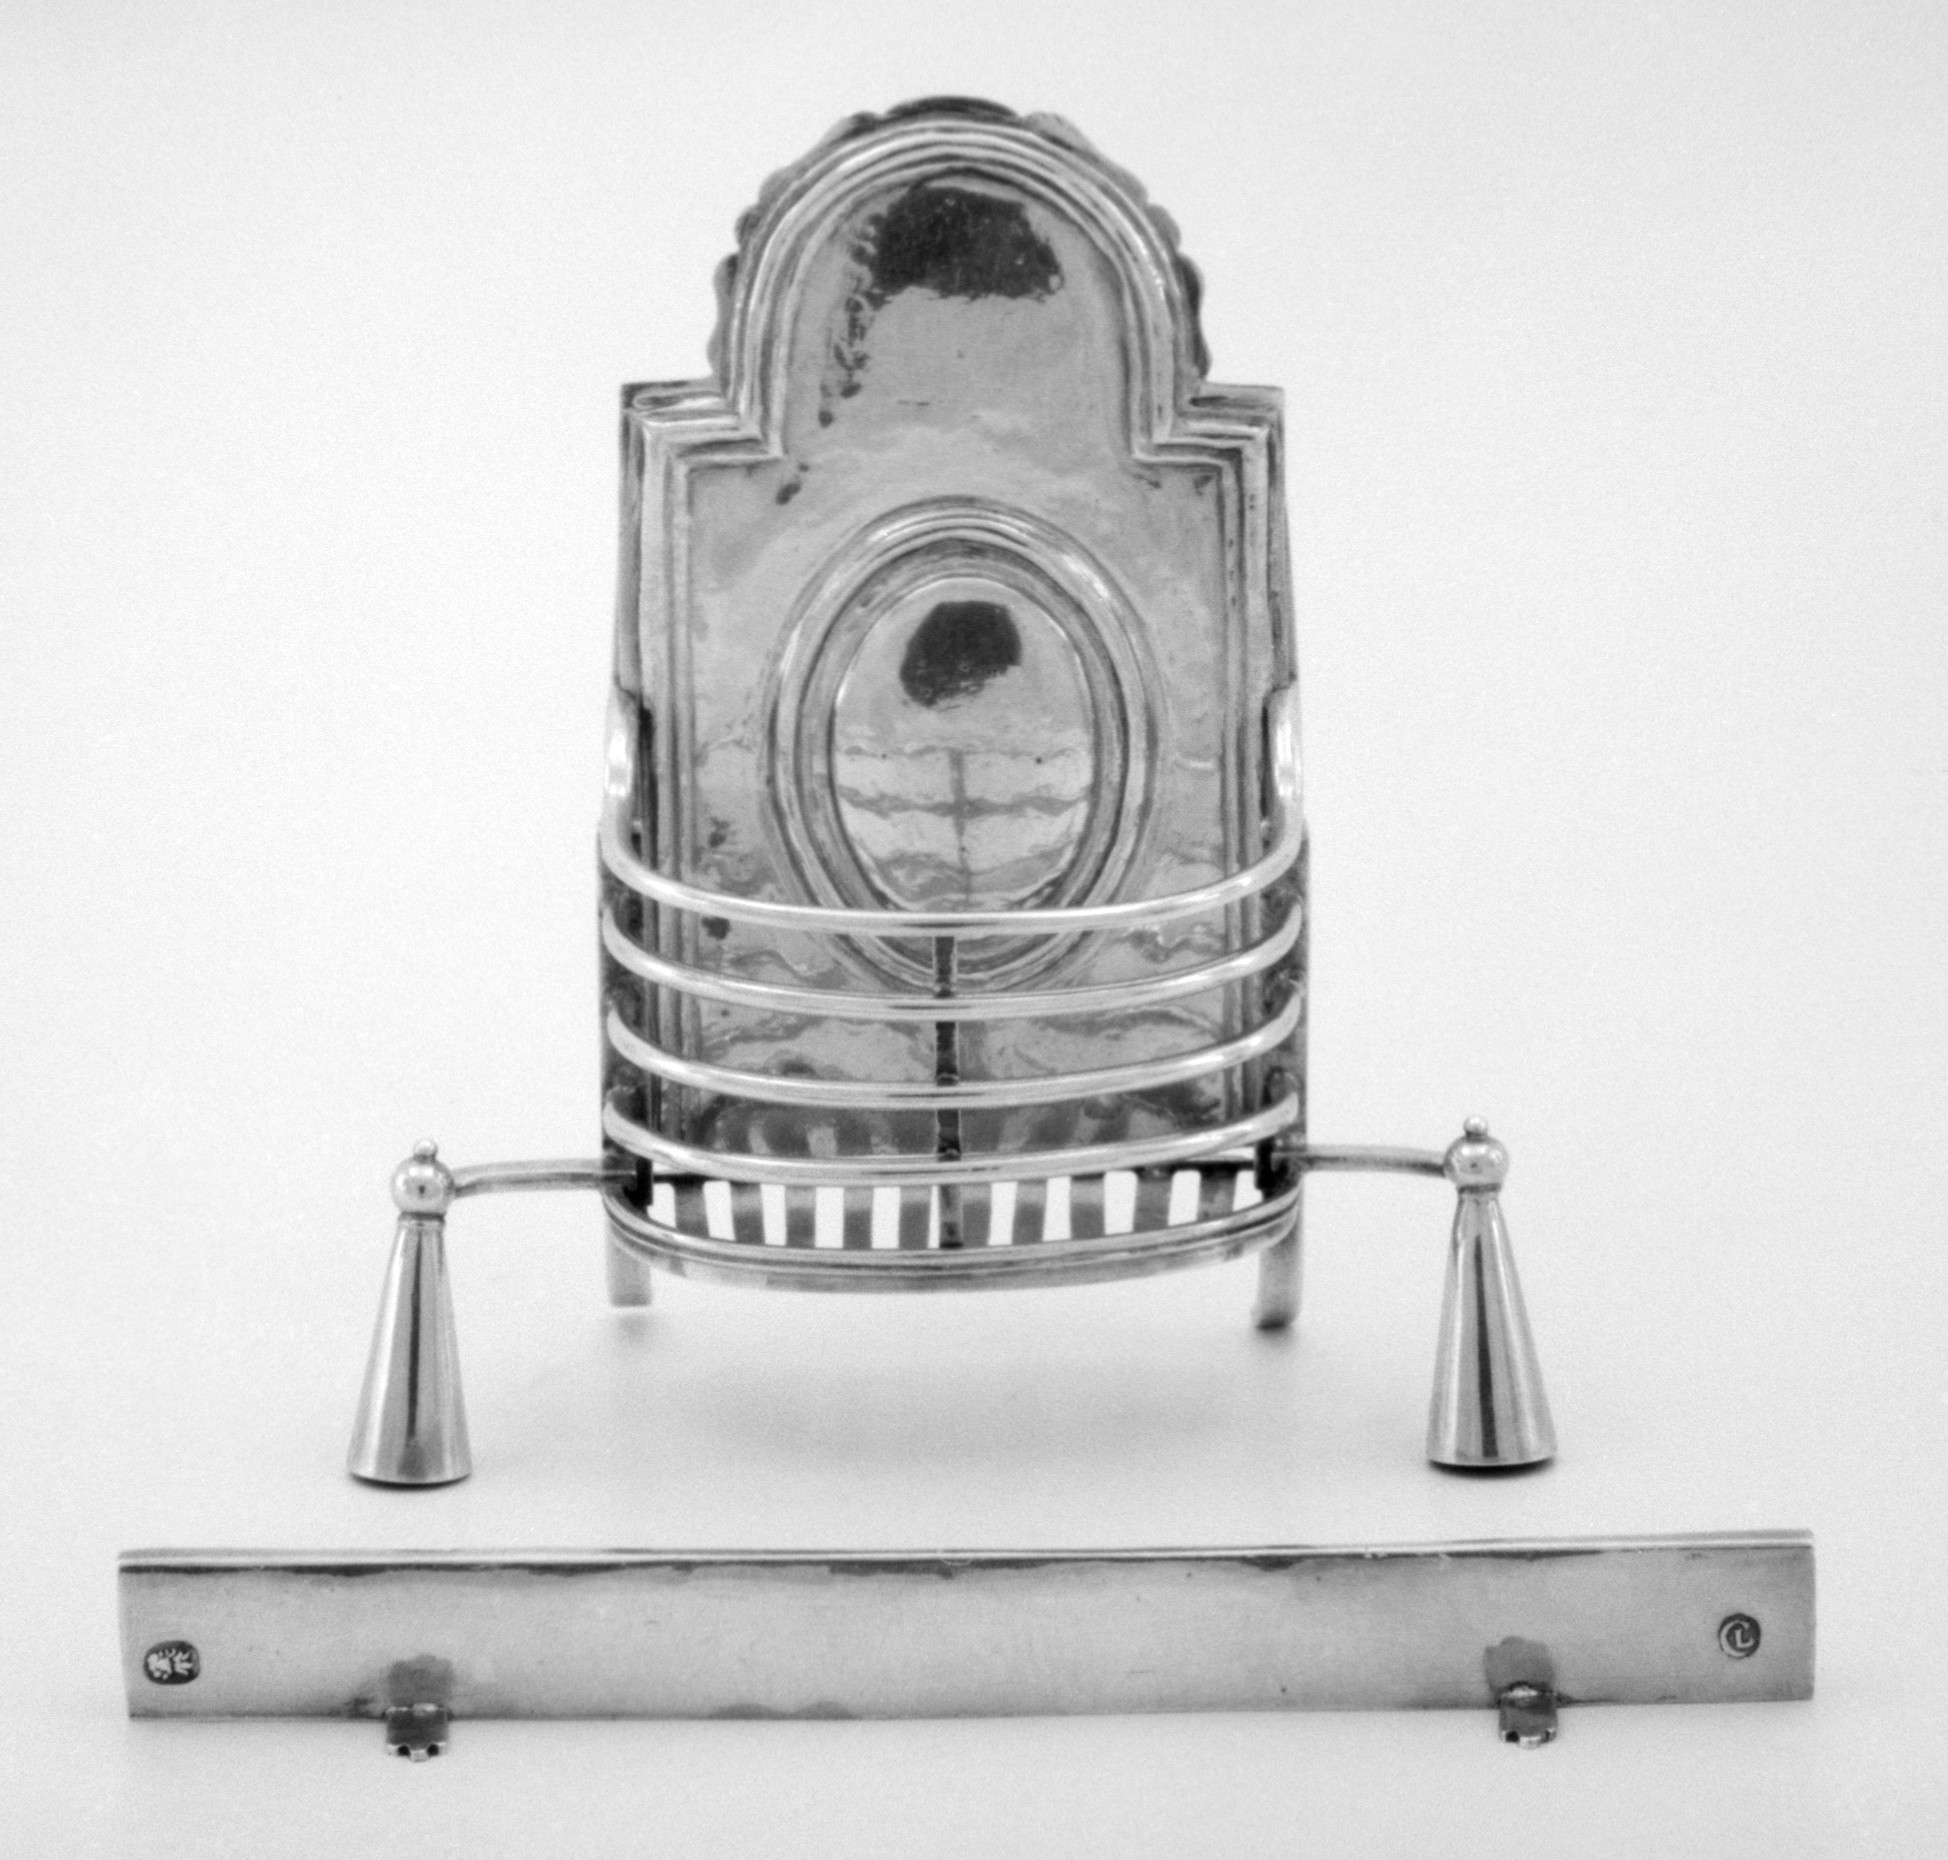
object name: fireback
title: Miniature fireback (part of a set)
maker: david clayton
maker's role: maker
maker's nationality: british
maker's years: 1659-1719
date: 1720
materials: silver